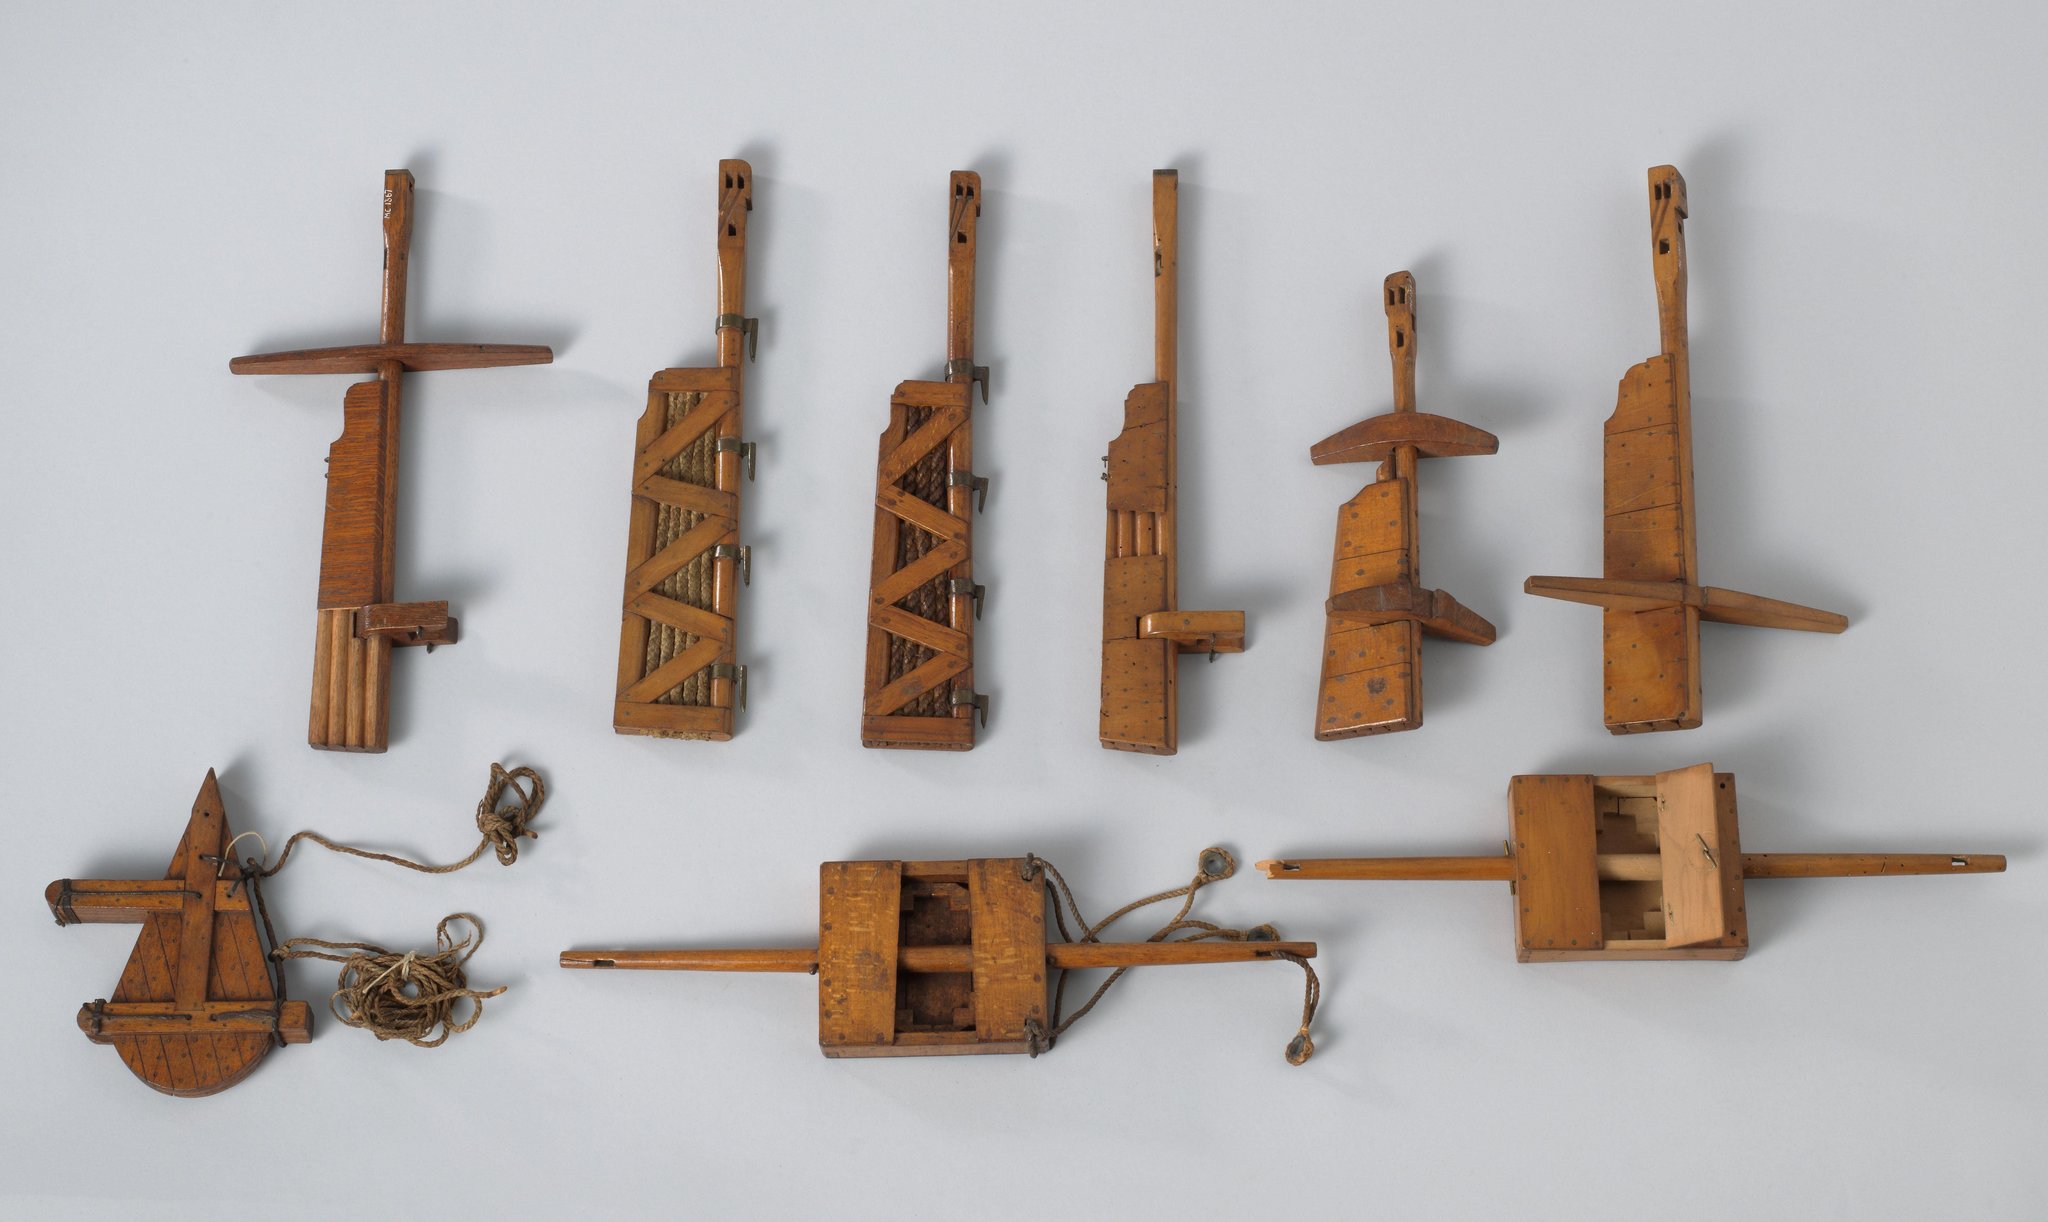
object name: demonstration model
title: Model of a Jury Rudder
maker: Anonymous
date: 1820-1870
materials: wood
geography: netherlands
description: Negen modellen van noodroeren. Drie noodroeren (nrs. 1-3) zijn bijna identiek aan de modellen NG-MC-228, 229 en 230. Ze hebben een steng als roerkoning en het roerblad is samengesteld uit rondhouten met planken bedekt. Twee daarvan (nrs. 1-2) hebben een ezelshoofd als roerhaak om de koning, bij de derde is hiervoor een ankerstok gebruikt. Eén noodroer (nr. 2) heeft een ankerstok om de roerkop, vergelijkbaar met model NG-MC-229 (Pakenhams noodroer). Het vierde model is een kleinere versie van dit type noodroer en heeft twee korte ankerstokken om de koning, een als roerhaak en een om de roerkop. Twee bijna identieke modellen (nrs. 5-6) zijn noodroeren met een steng als roerkoning en het roerblad is samengesteld uit trossen die door planken bijeen worden gehouden; deze modellen hebben speciale messing roerhaken. Het zevende model, van planken gemaakt, heeft een druppelvorm en is vermoedelijk gebaseerd op het ontwerp van Bassiere. Het laatste paar modellen (nrs. 8-9) bestaat uit een ra waar een kast omheen is gebouwd. De hoeken van de kast zijn aan de binnenkant verstevigd met de wangen van rolpaarden. Eén model (nr. 8) is voorzien van stroppen aan één kant, vermoedelijk voor de bevestiging van stuurtalies.